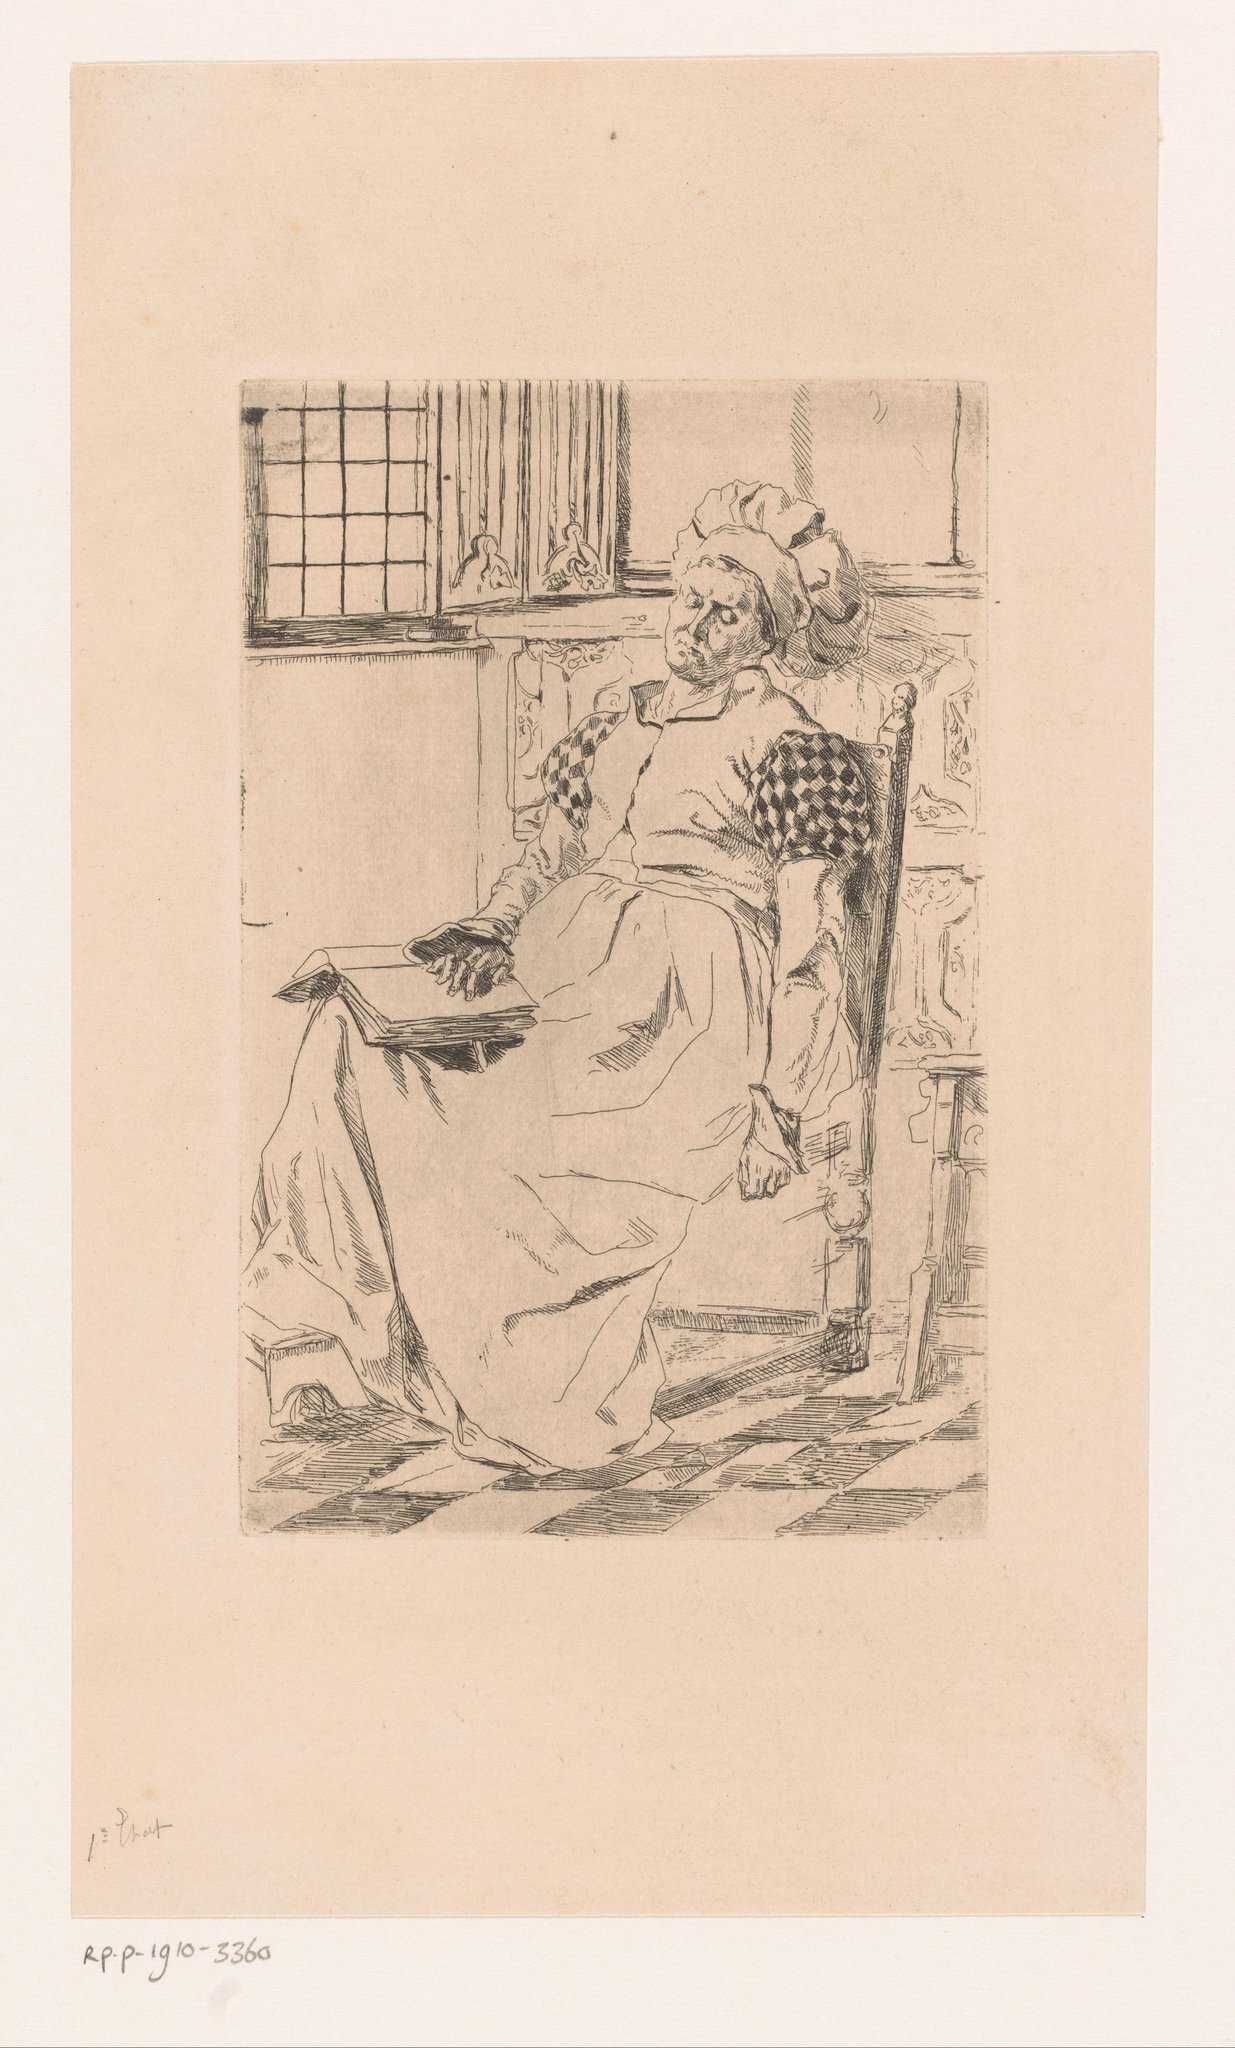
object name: print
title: Slapende vrouw op een stoel met boek op schoot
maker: willem geets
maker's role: print maker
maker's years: 1838-1919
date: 1848-1910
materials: paper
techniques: etching, intaglio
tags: sleeping in chair, book - mm - book open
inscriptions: collector's mark: Lugt 2228